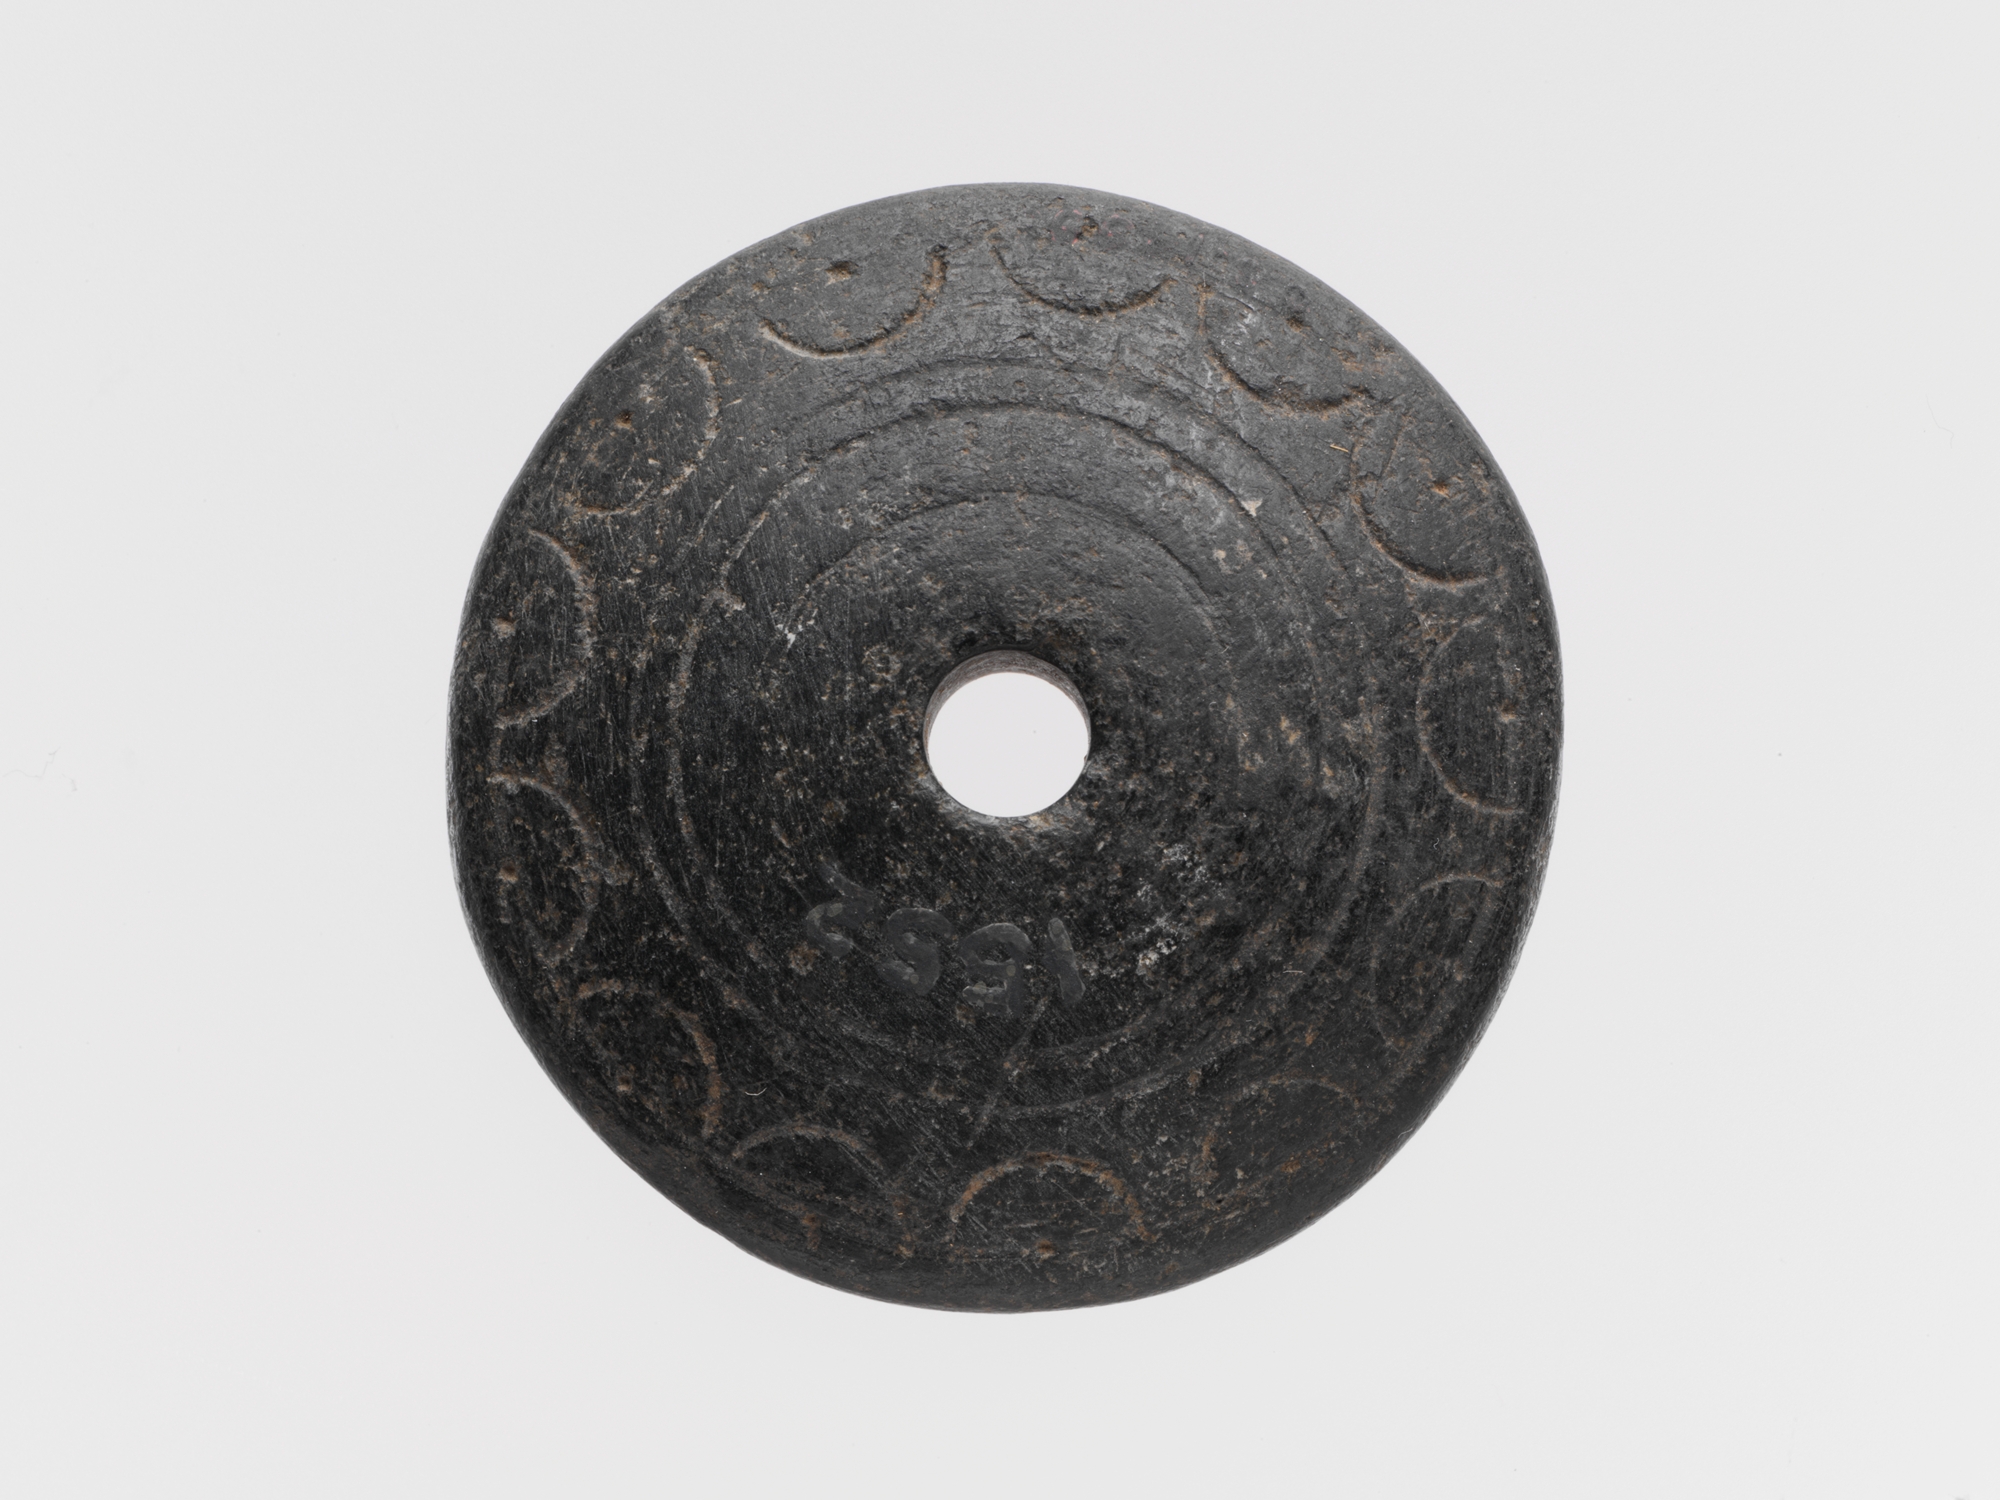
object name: spindle whorl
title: Chlorite spindle whorl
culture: cypriot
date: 1200-1050 BCE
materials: mineral